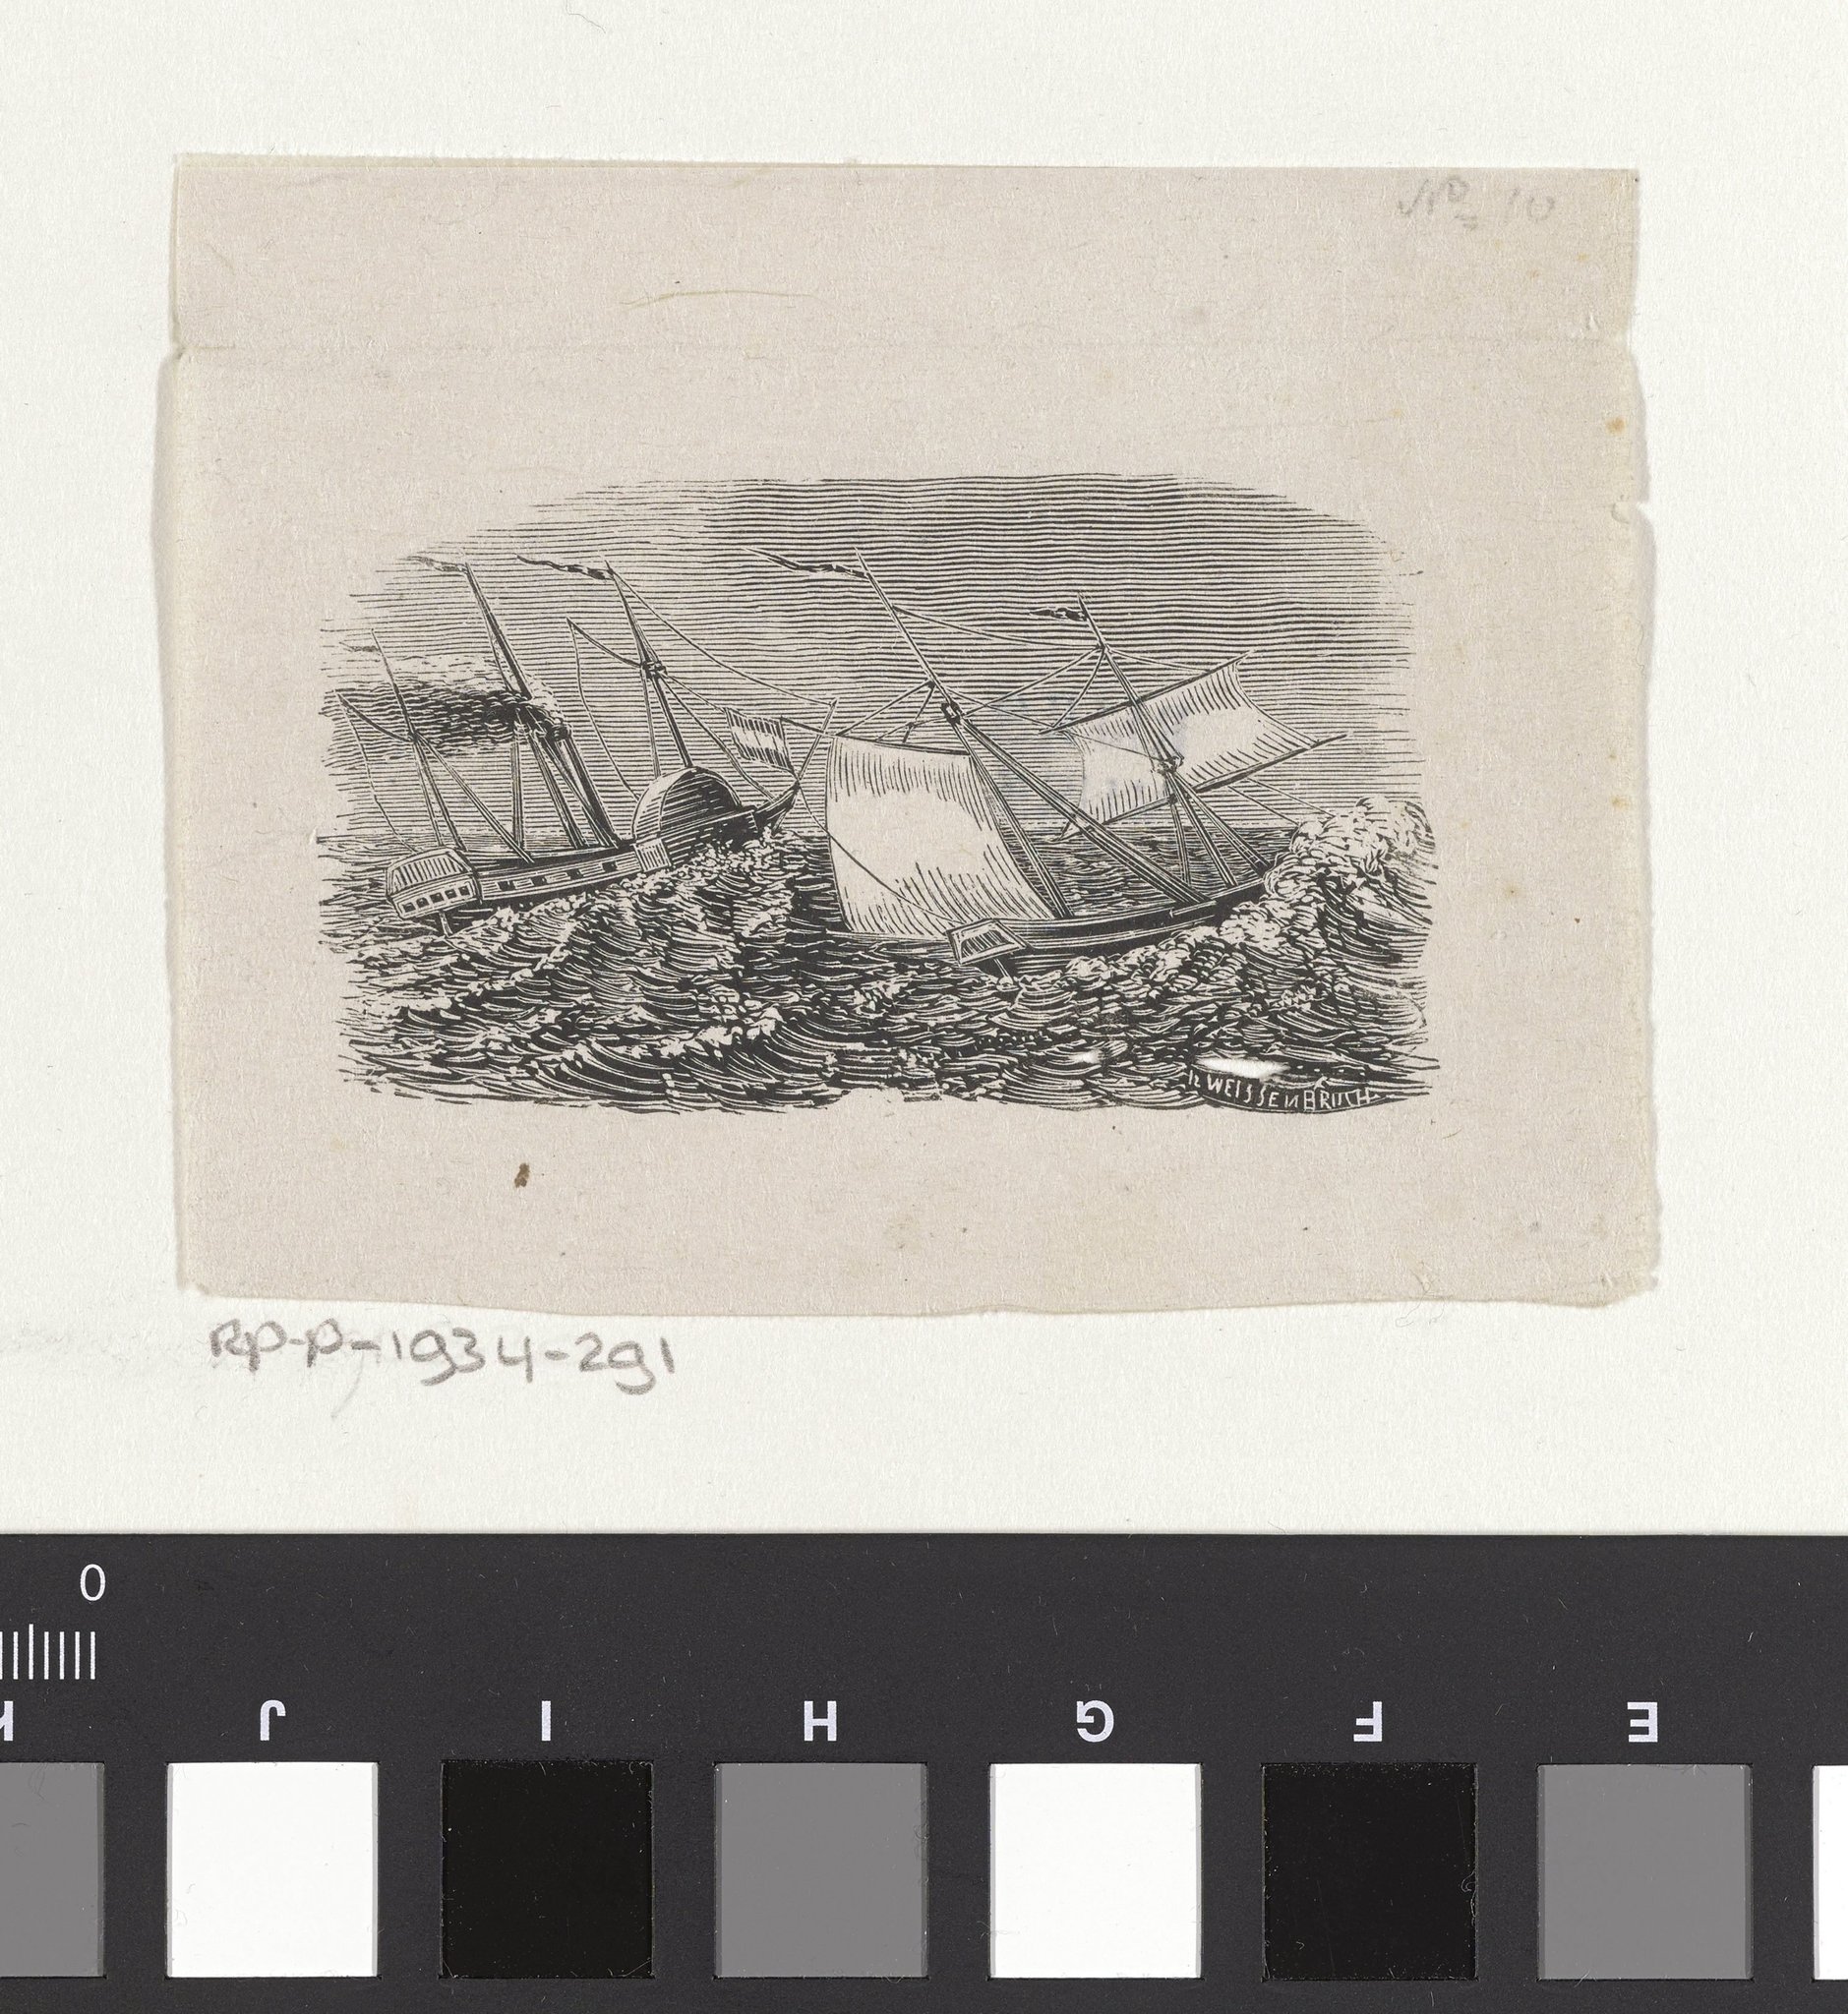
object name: print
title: Schepen in een storm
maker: isaac weissenbruch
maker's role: print maker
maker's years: 1826-1912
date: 1836-1912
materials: paper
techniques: engraving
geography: netherlands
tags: ships (in general), storm at sea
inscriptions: collector's mark: Lugt 2166